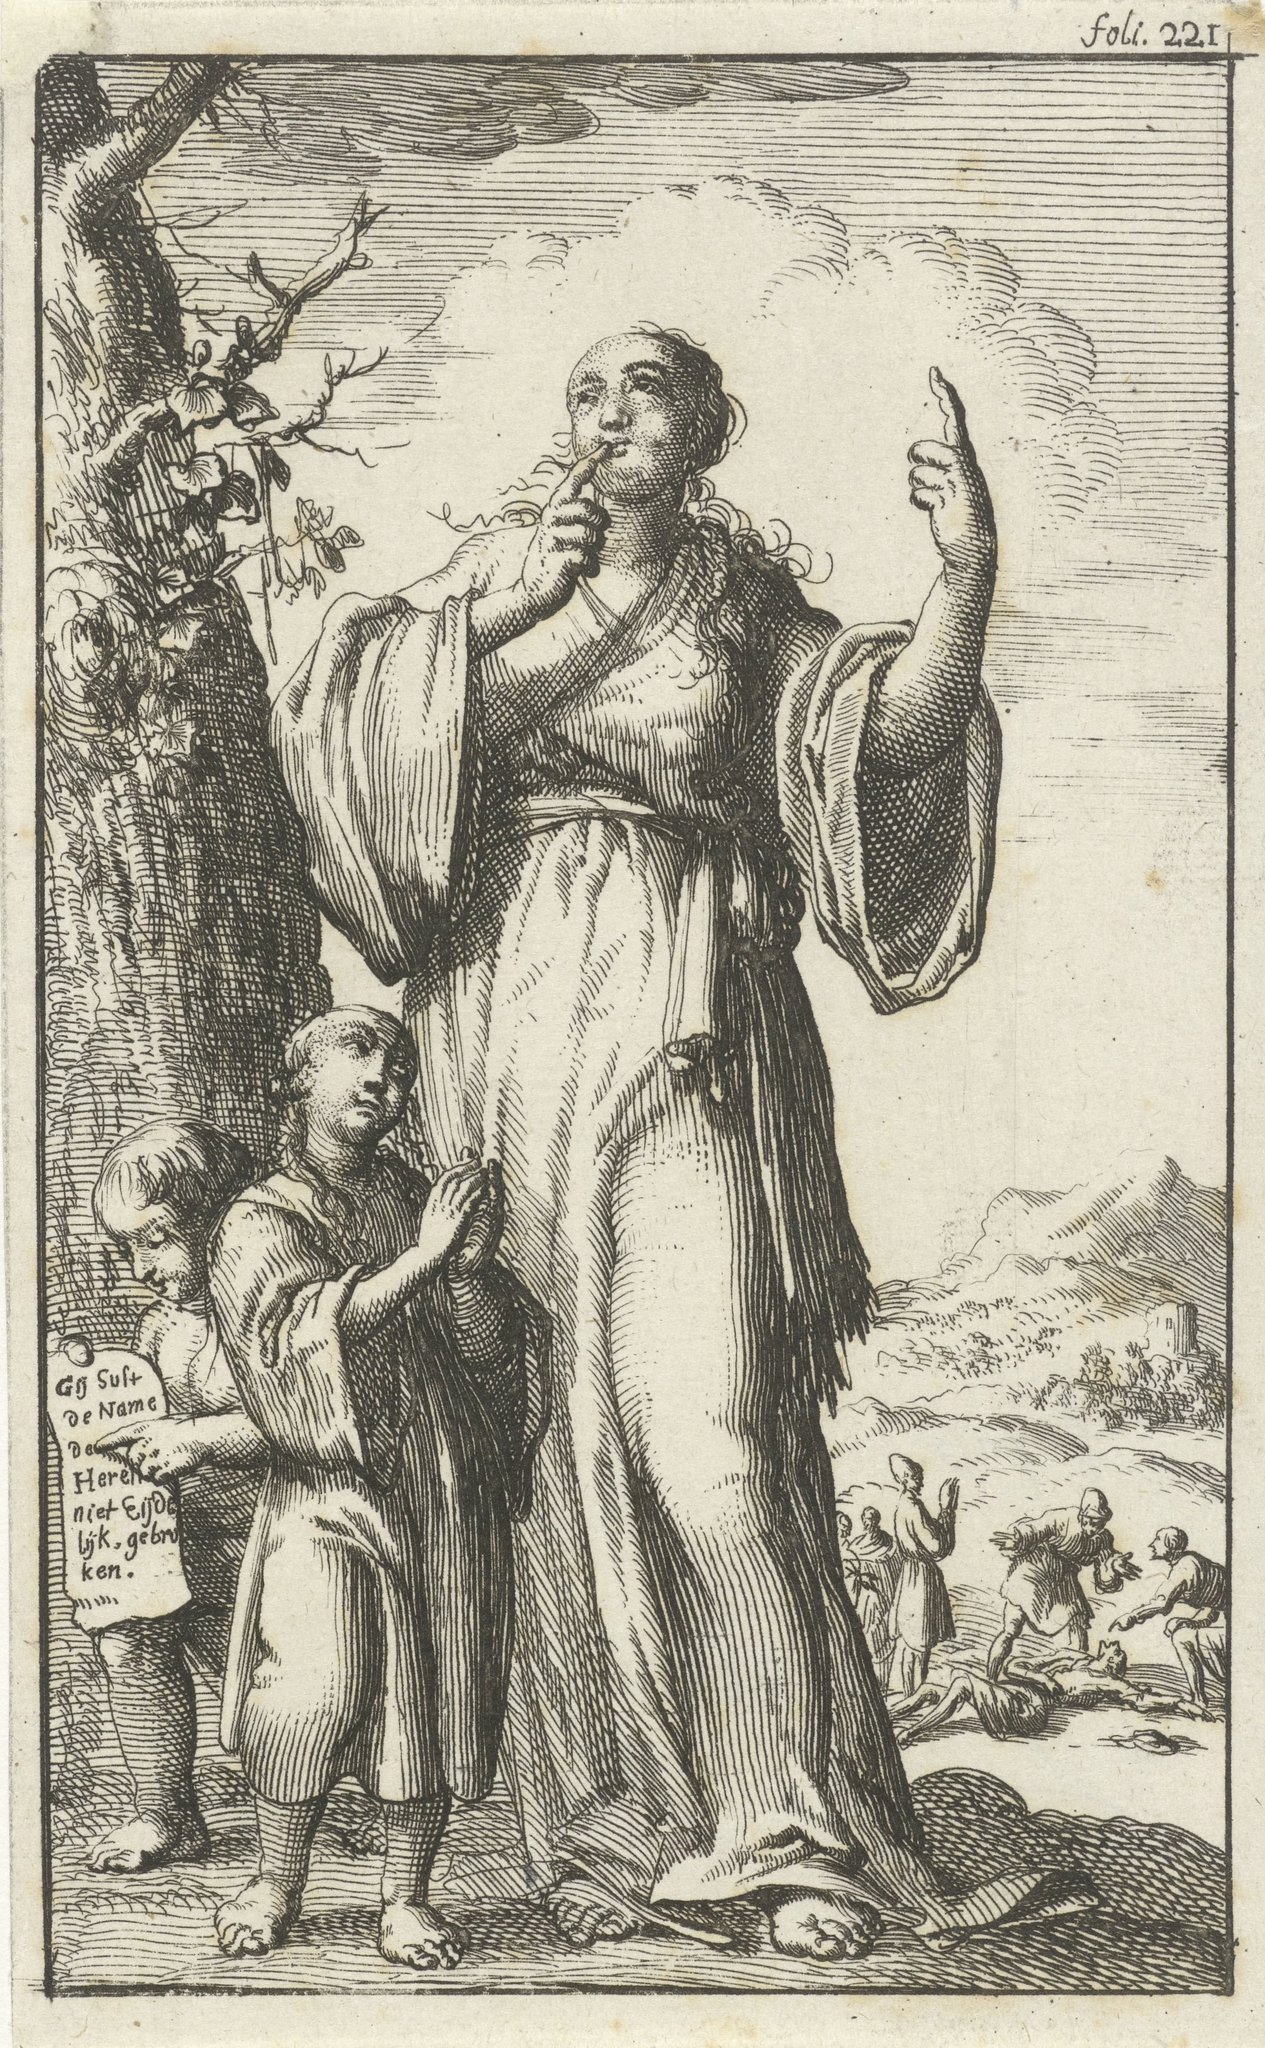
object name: print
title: Gij zult de naam van de Heer uw God niet ijdel gebruiken: het tweede Gebod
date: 1685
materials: paper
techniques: etching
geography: amsterdam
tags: index finger forwards, pointing, indicating (+ indicating, pointing at), putting a finger to the lips, 'silentium'; 'silentio' (ripa), 'you shall not take the name of the lord your god in vain' ~ separate representation of the third of the ten commandments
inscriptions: collector's mark: Lugt 2228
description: Vrouw drukt een wijsvinger op haar lippen en wijst naar de lucht. Genummerd rechtsboven: foli 221.